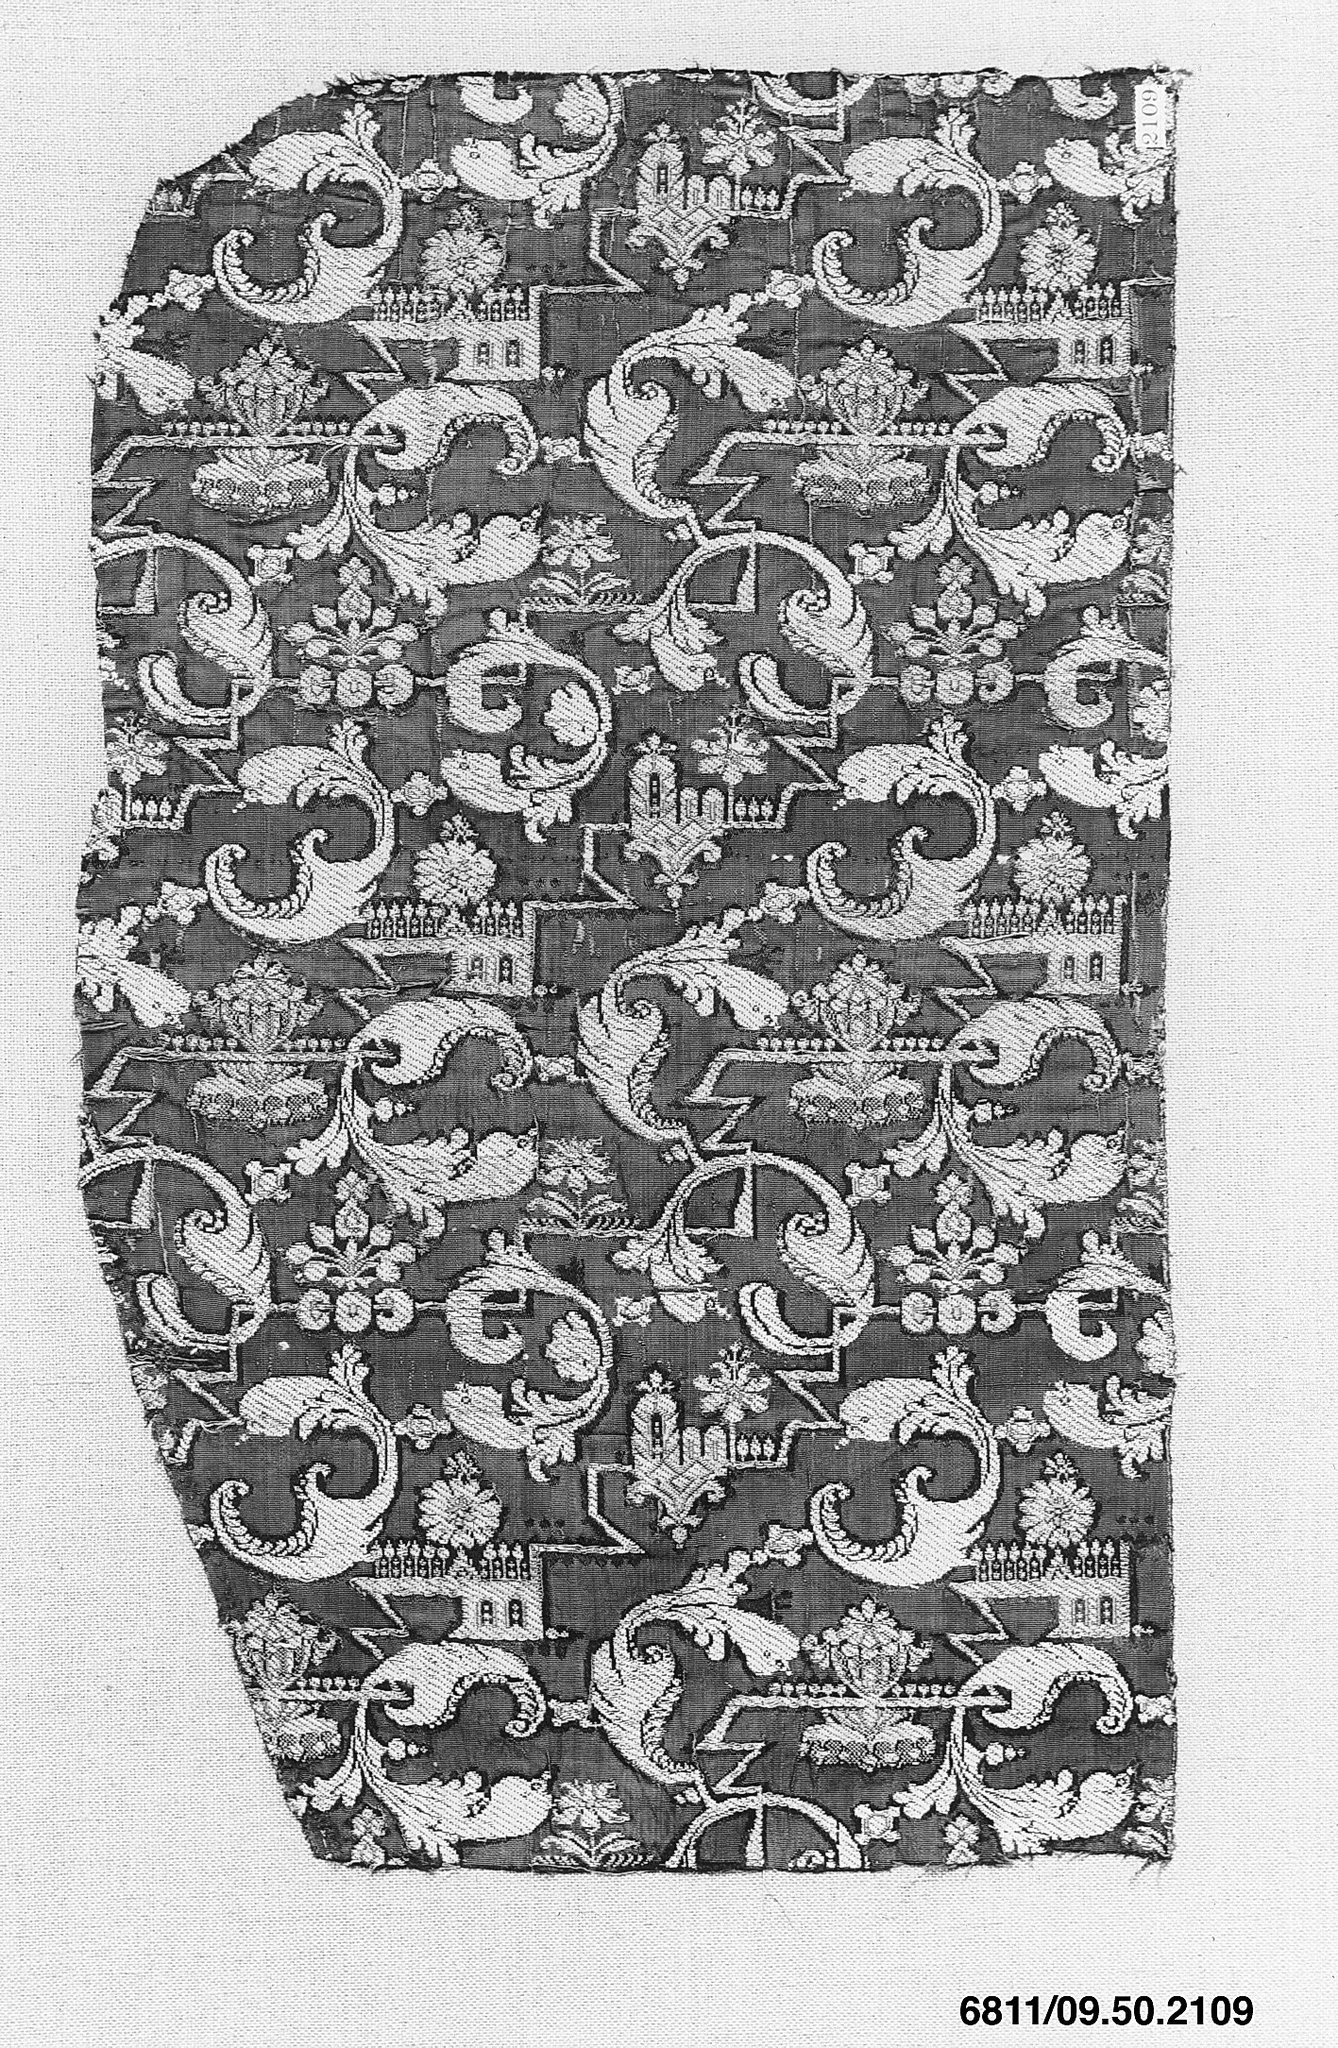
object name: piece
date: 1701-1733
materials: metal thread, silk